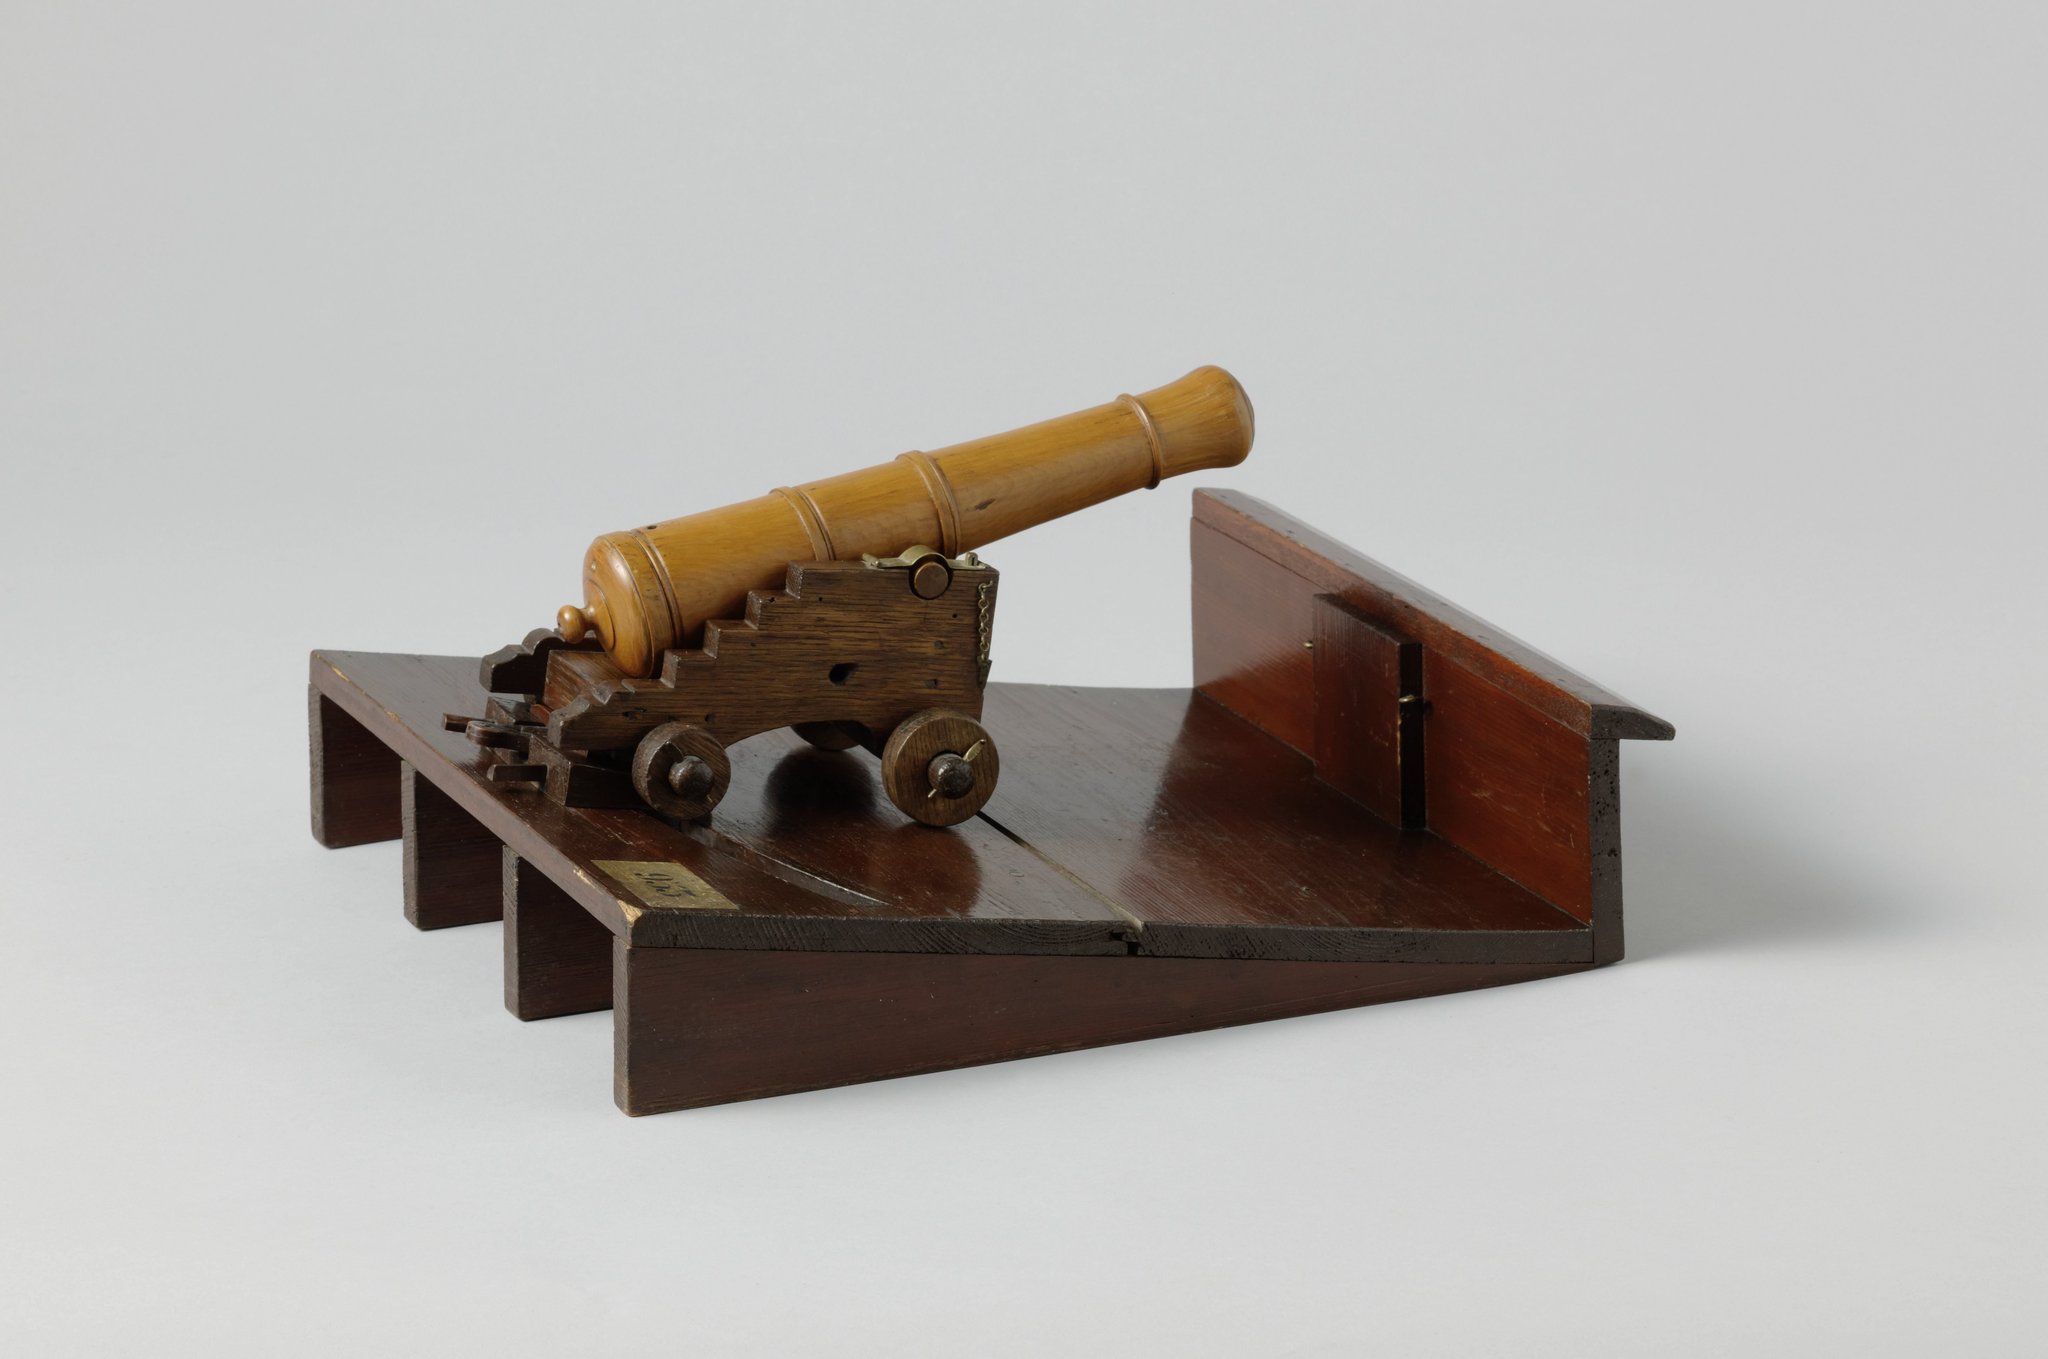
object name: gunmodel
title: Model of a Gun and Carriage on a Ship Deck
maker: jochem pietersz. asmus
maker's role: constructeur, directeur, equipagemeester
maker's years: 1755-1837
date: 1796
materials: brass, wood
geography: amsterdam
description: Model van een kanon op rolpaard op een schuin dek met boord aan de lage kant. De houten loop is 26 cm lang. Het rolpaard, voor smaller dan achter, bestaat uit twee wangen met vier trappen en een boogvormige uitsnede onderaan, die verbonden worden door het kalf, een borststuk, een dwarsbalk in het midden, de zoolplaat en een balk onder de zoolplaat, en de aslijven. De stelwig ontbreekt. De wielen zijn van hout en de voorwielen zijn groter dan de achterwielen. In het dek is boven een mechanisme aangebracht dat onder het achterste aslijf van het rolpaard haakt en het boven vasthoudt; dit mechaniek kan in een uitgesneden cirkelsegment heen en weer bewegen, aldus de hoek wijzigend waaronder het rolpaard, eenmaal losgemaakt, naar beneden zal rollen. Daar waar het rolpaard tegen het boord terechtkomt, is het boord verstevigd met een kussenblok aan de binnenzijde.